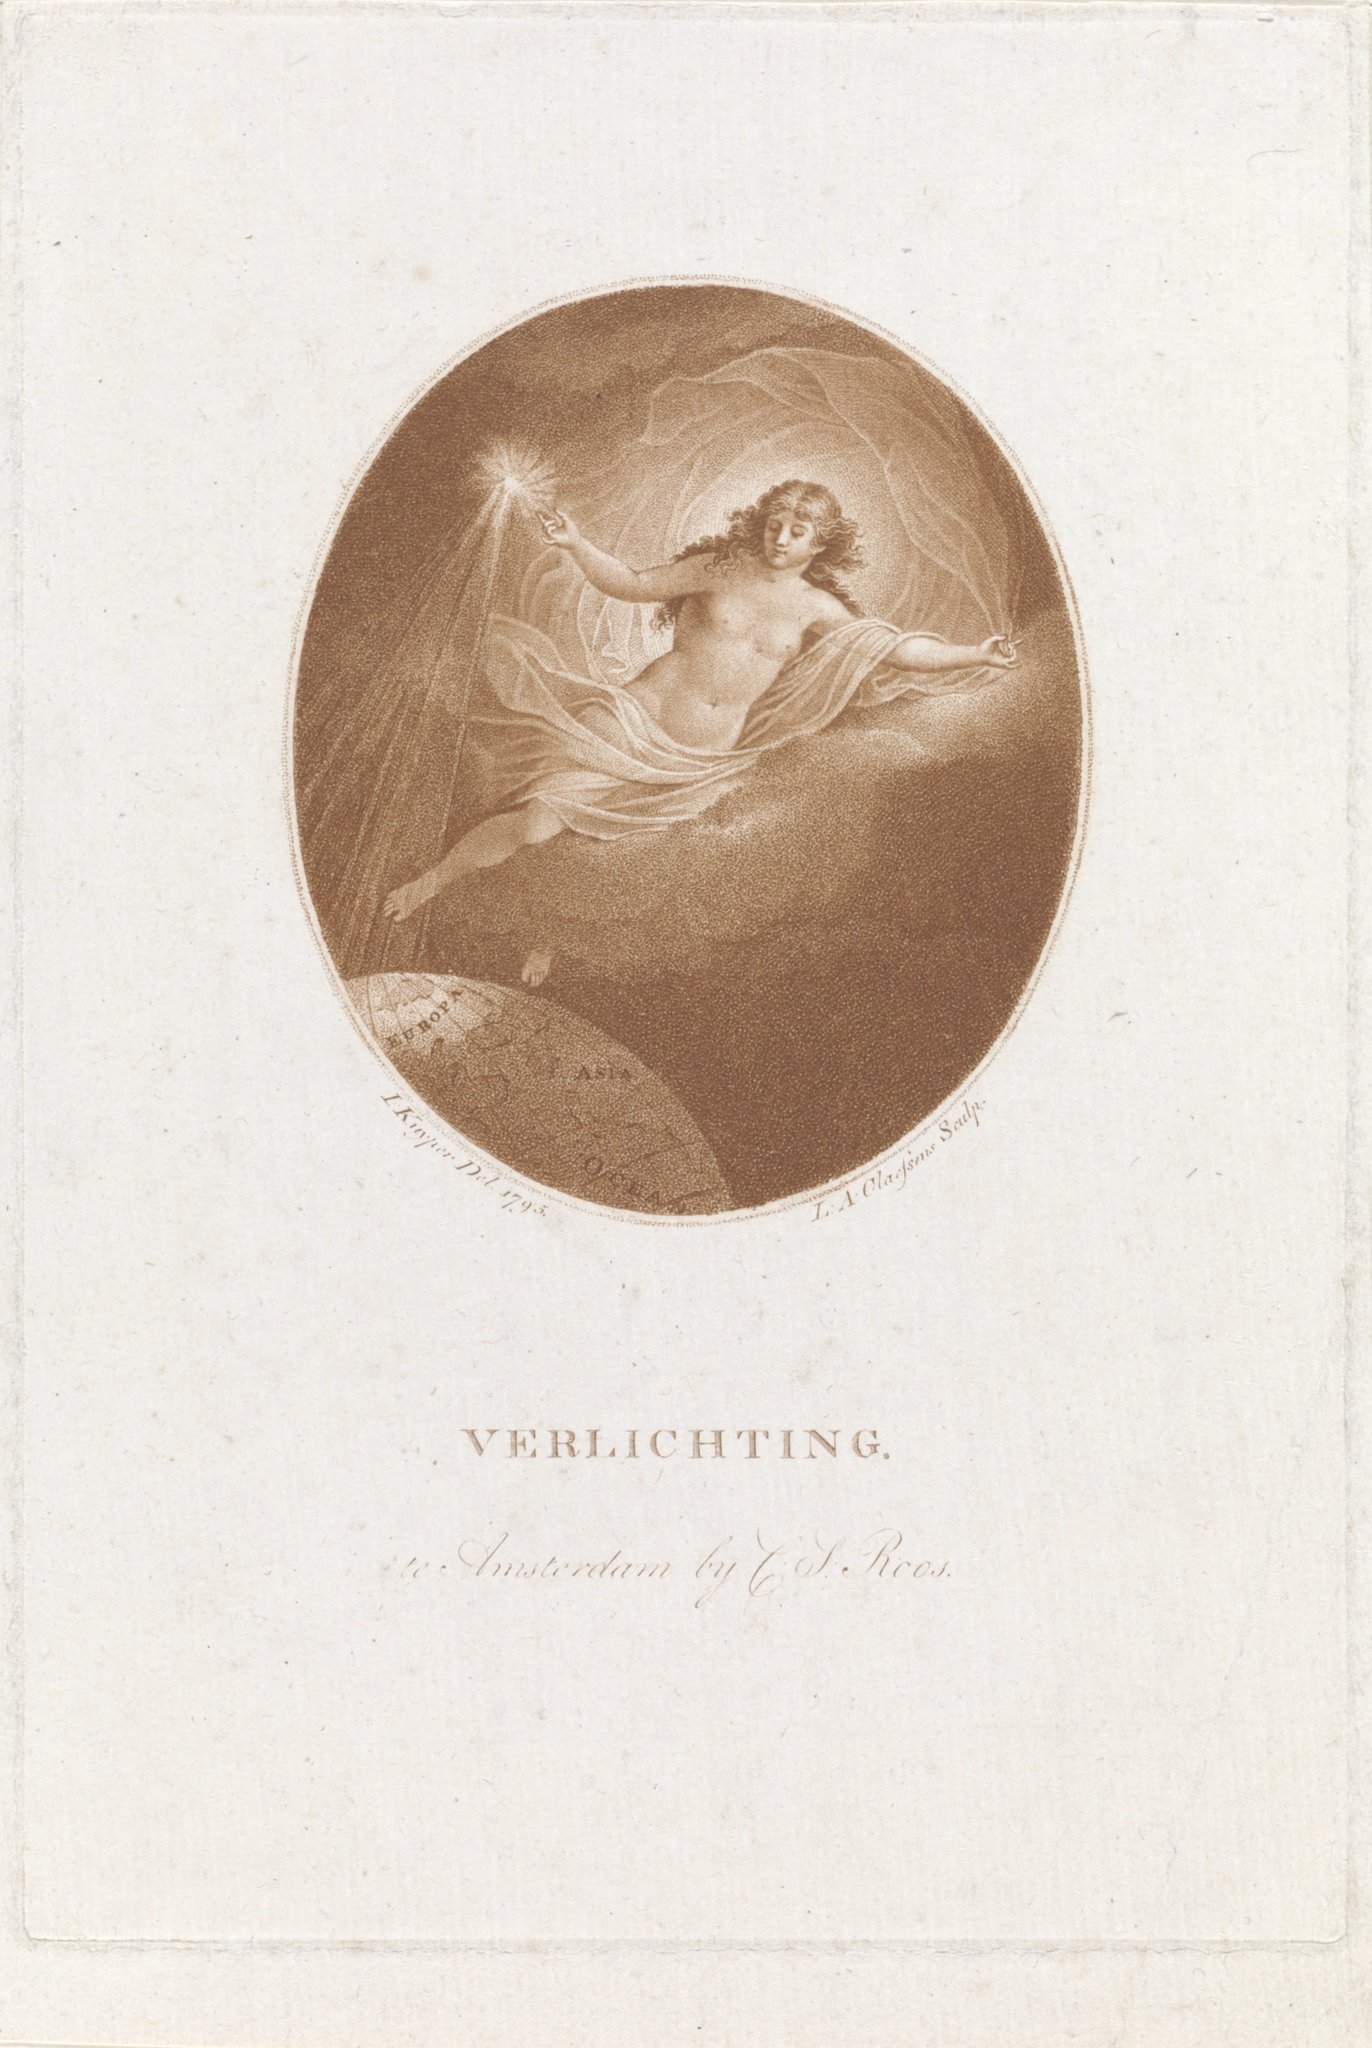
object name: print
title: Verlichting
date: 1795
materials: paper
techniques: printing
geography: netherlands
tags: light shining out of the heavens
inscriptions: collector's mark: Lugt 2228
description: Allegorie op de Verlichting, 1795. De vrouwelijke personificatie van de Verlichting zweeft boven de wereld en laat haar licht op Europa schijnen.